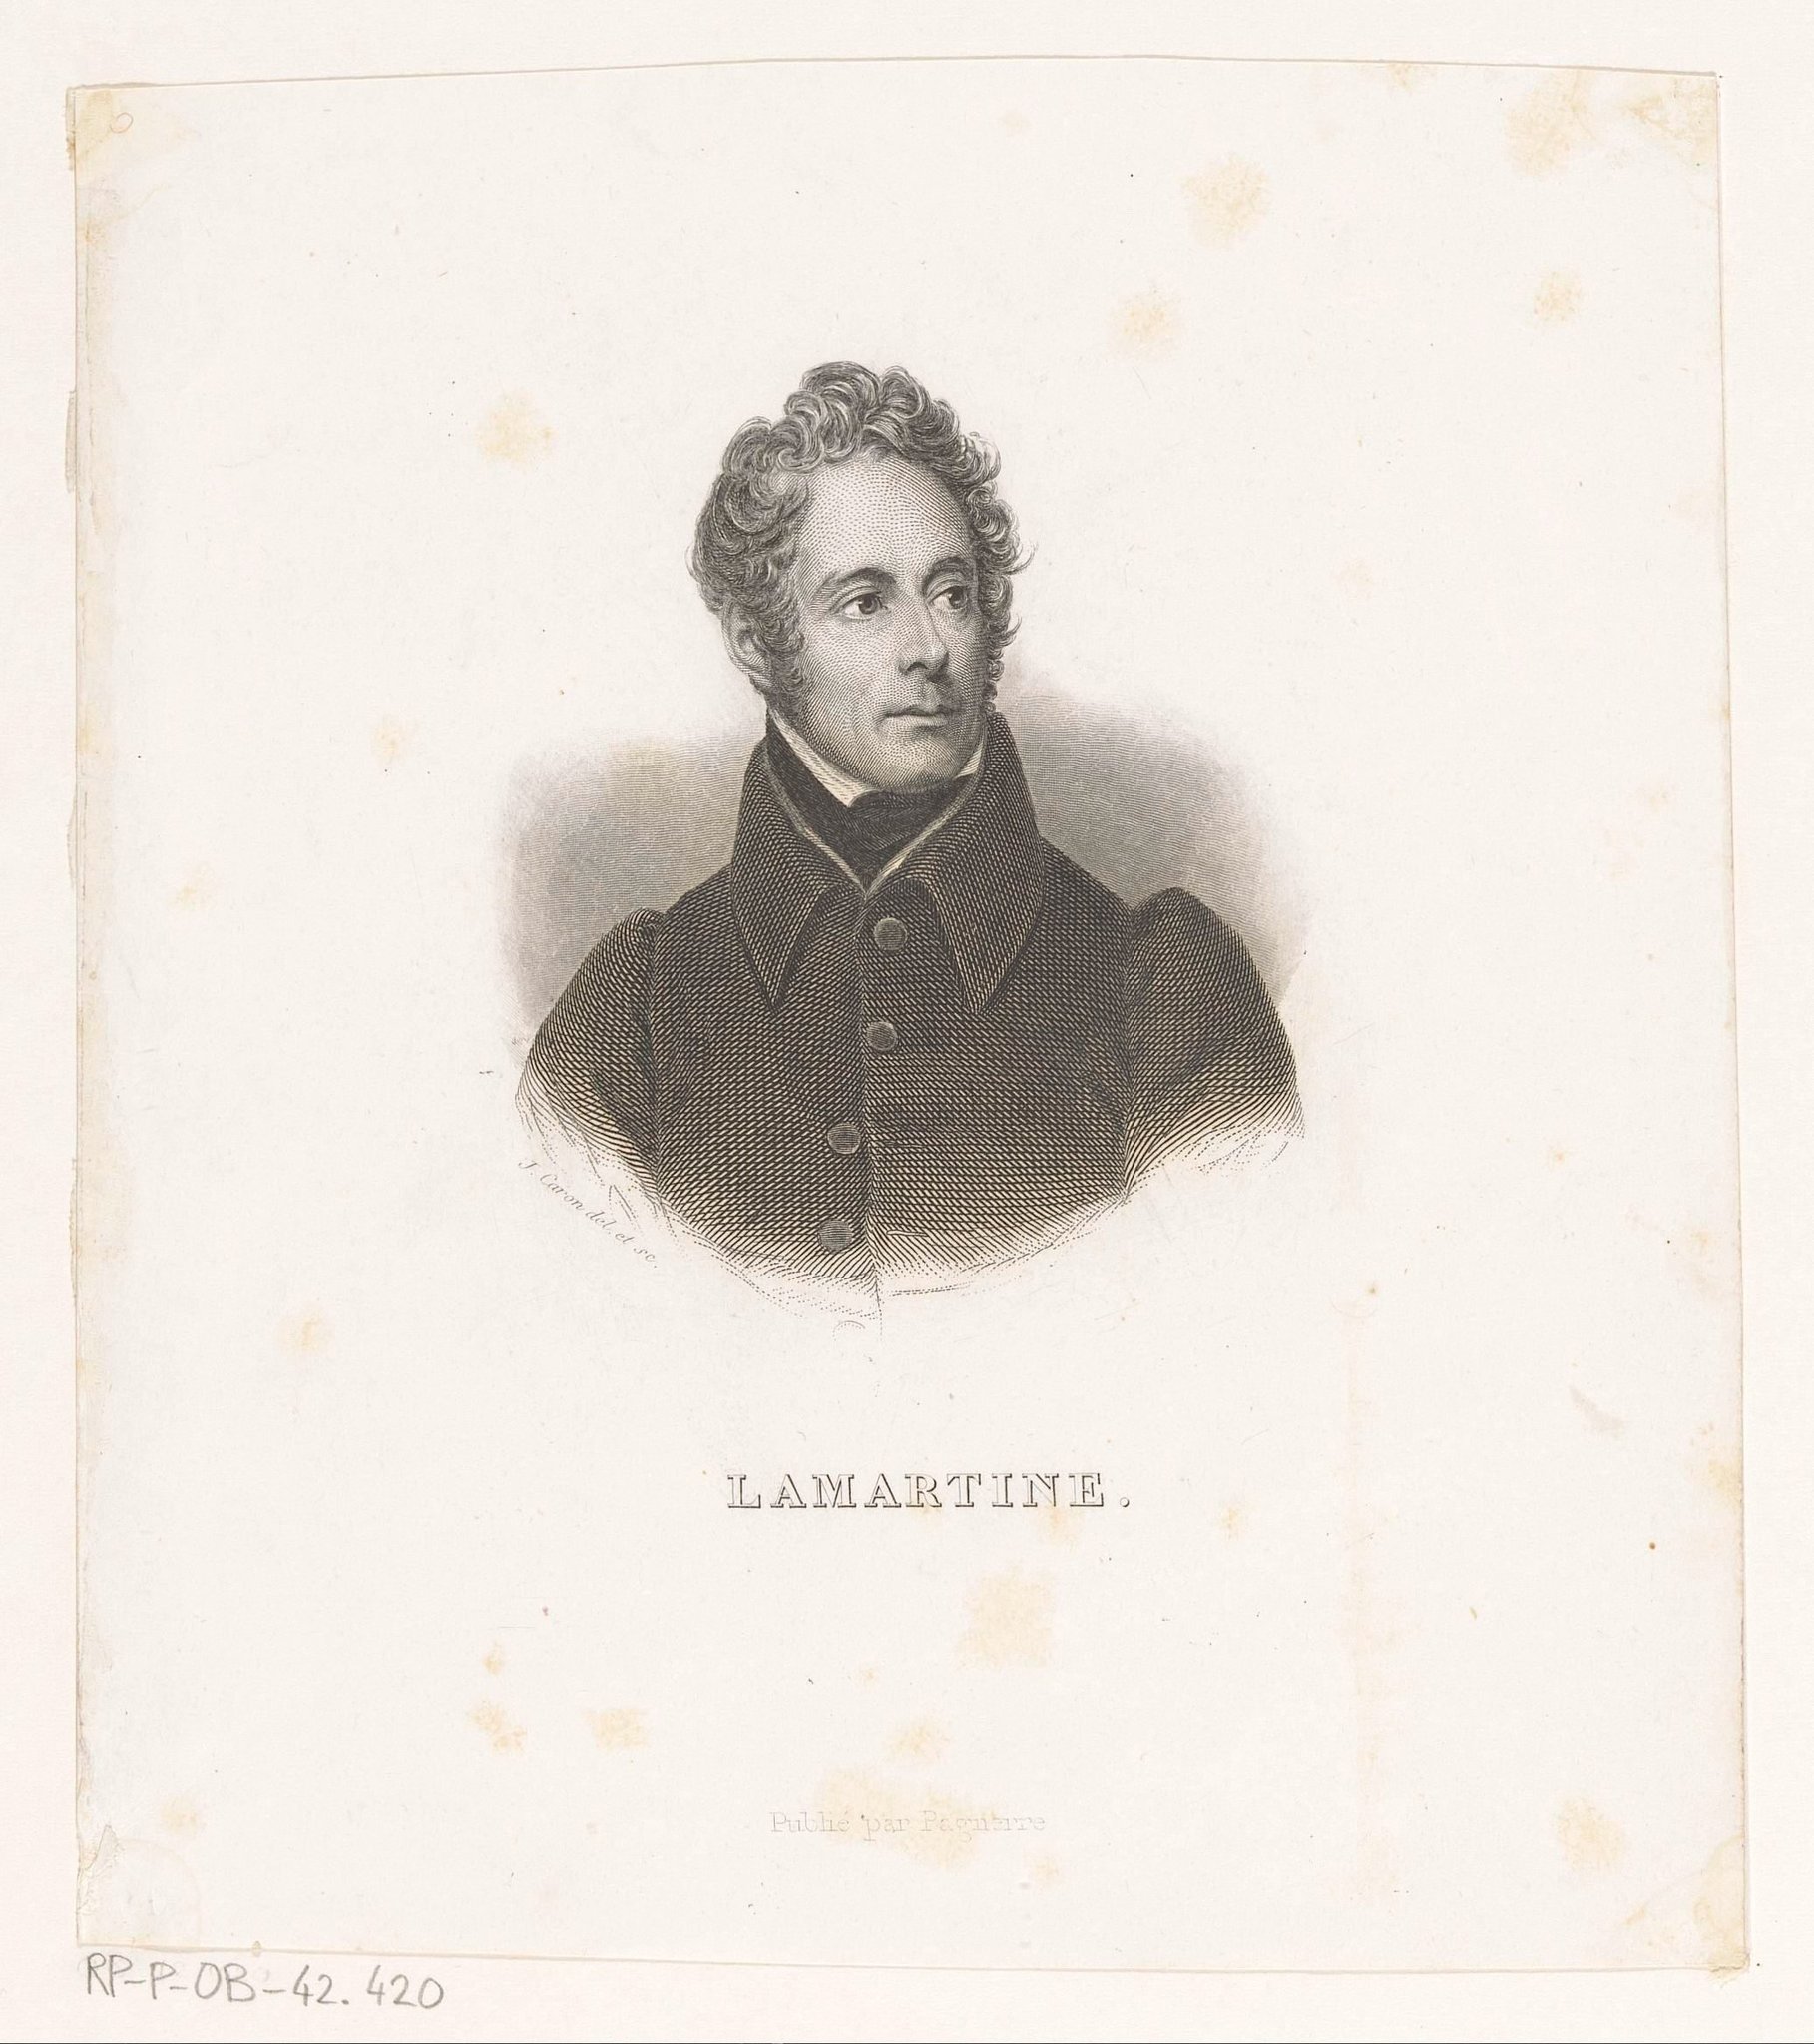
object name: book illustration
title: Portret van Alphonse de Lamartine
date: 1842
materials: paper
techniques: engraving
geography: france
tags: paris, historical persons, portrait of a writer, politician, e.g. party leader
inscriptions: collector's mark: Lugt 2228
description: Prent uit: Cormenin, Louis-Marie de Lahaye. Livre des orateurs. Parijs: L.A. Pagnerre, 1842. Betreft illustratie bij p. 489.